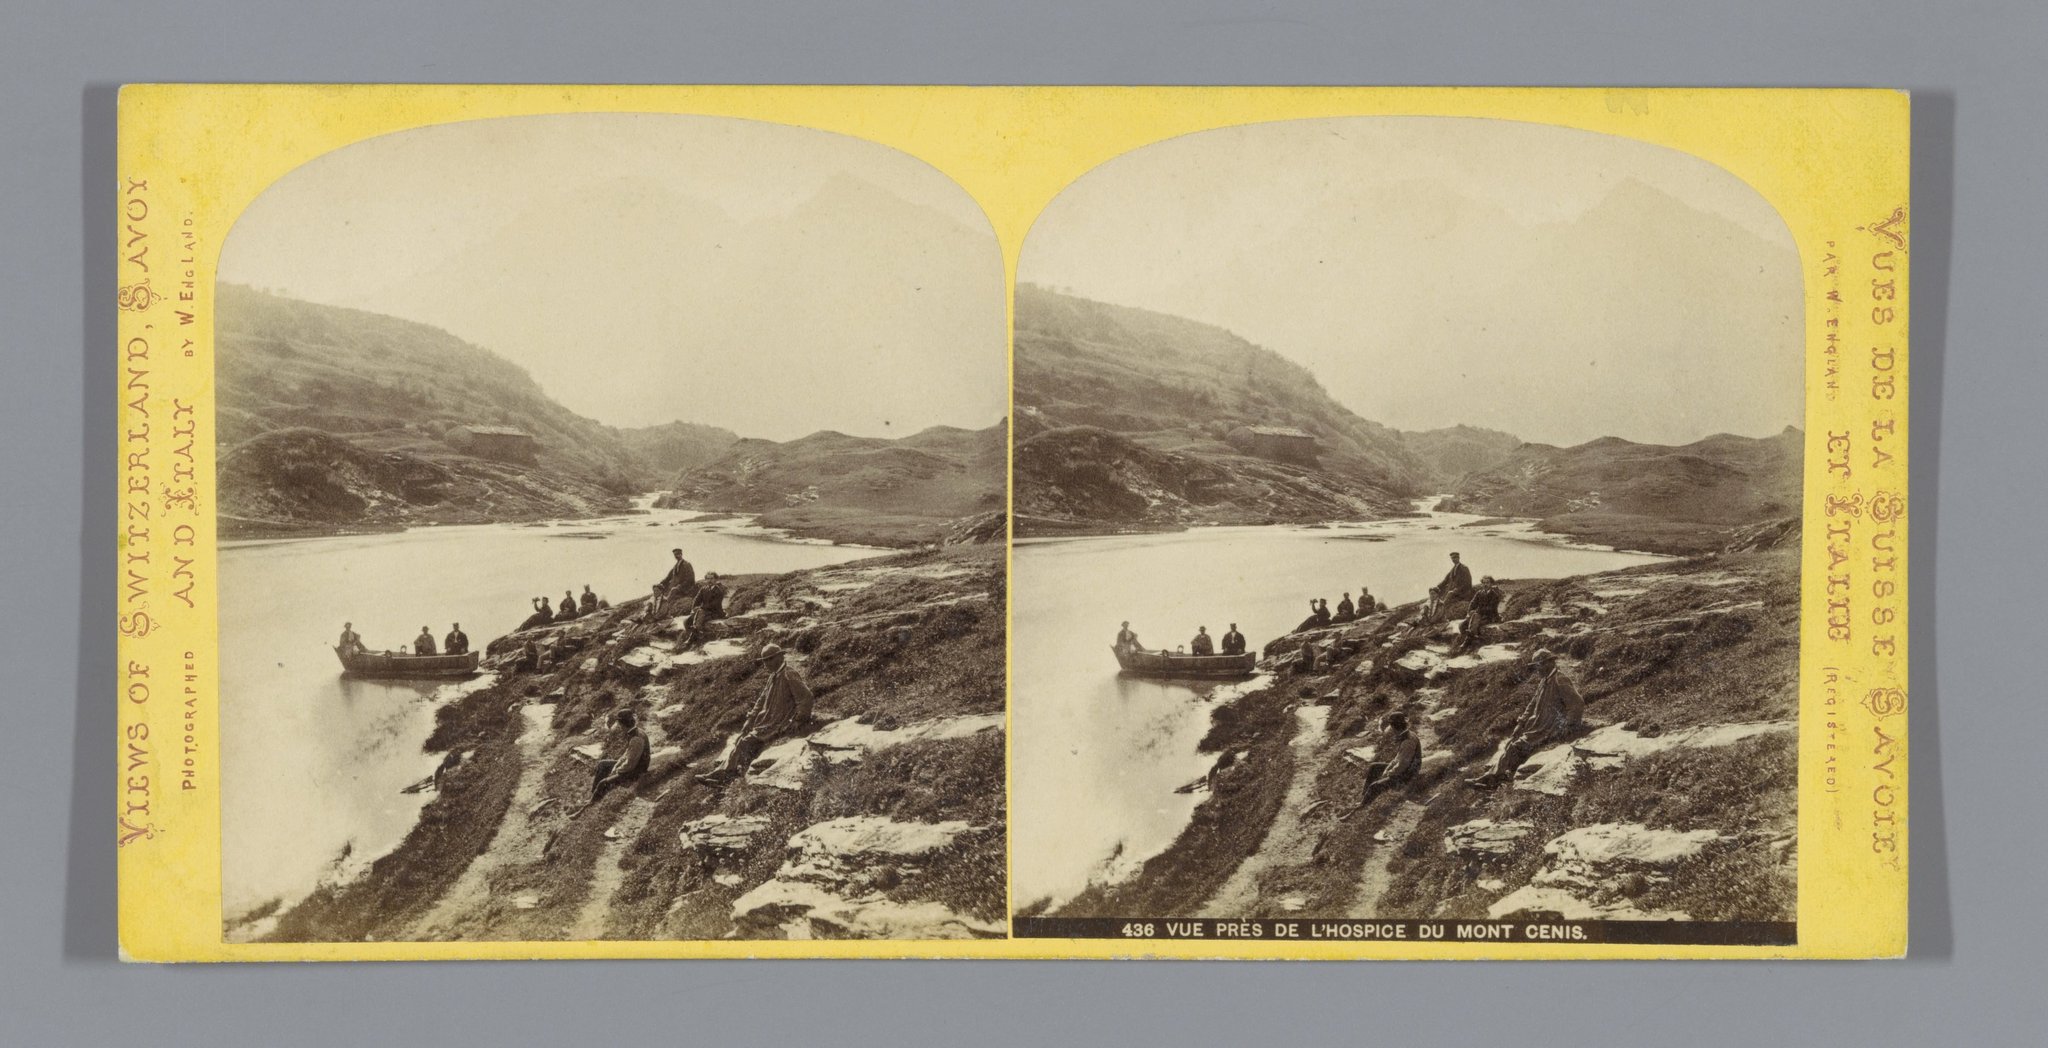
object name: stereograph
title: Gezicht op het Lac du Mont-Cenis met bezoekers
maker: william england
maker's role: fotograaf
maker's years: 1816-1896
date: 1850-1880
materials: cardboard, photographic support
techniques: albumen print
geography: col du mont cenis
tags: rowing-boat, canoe, etc., lake (+ landscape with figures, staffage)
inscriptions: inscription: ‘Vues de la Suisse Savoie et Italie’, number: ‘436’